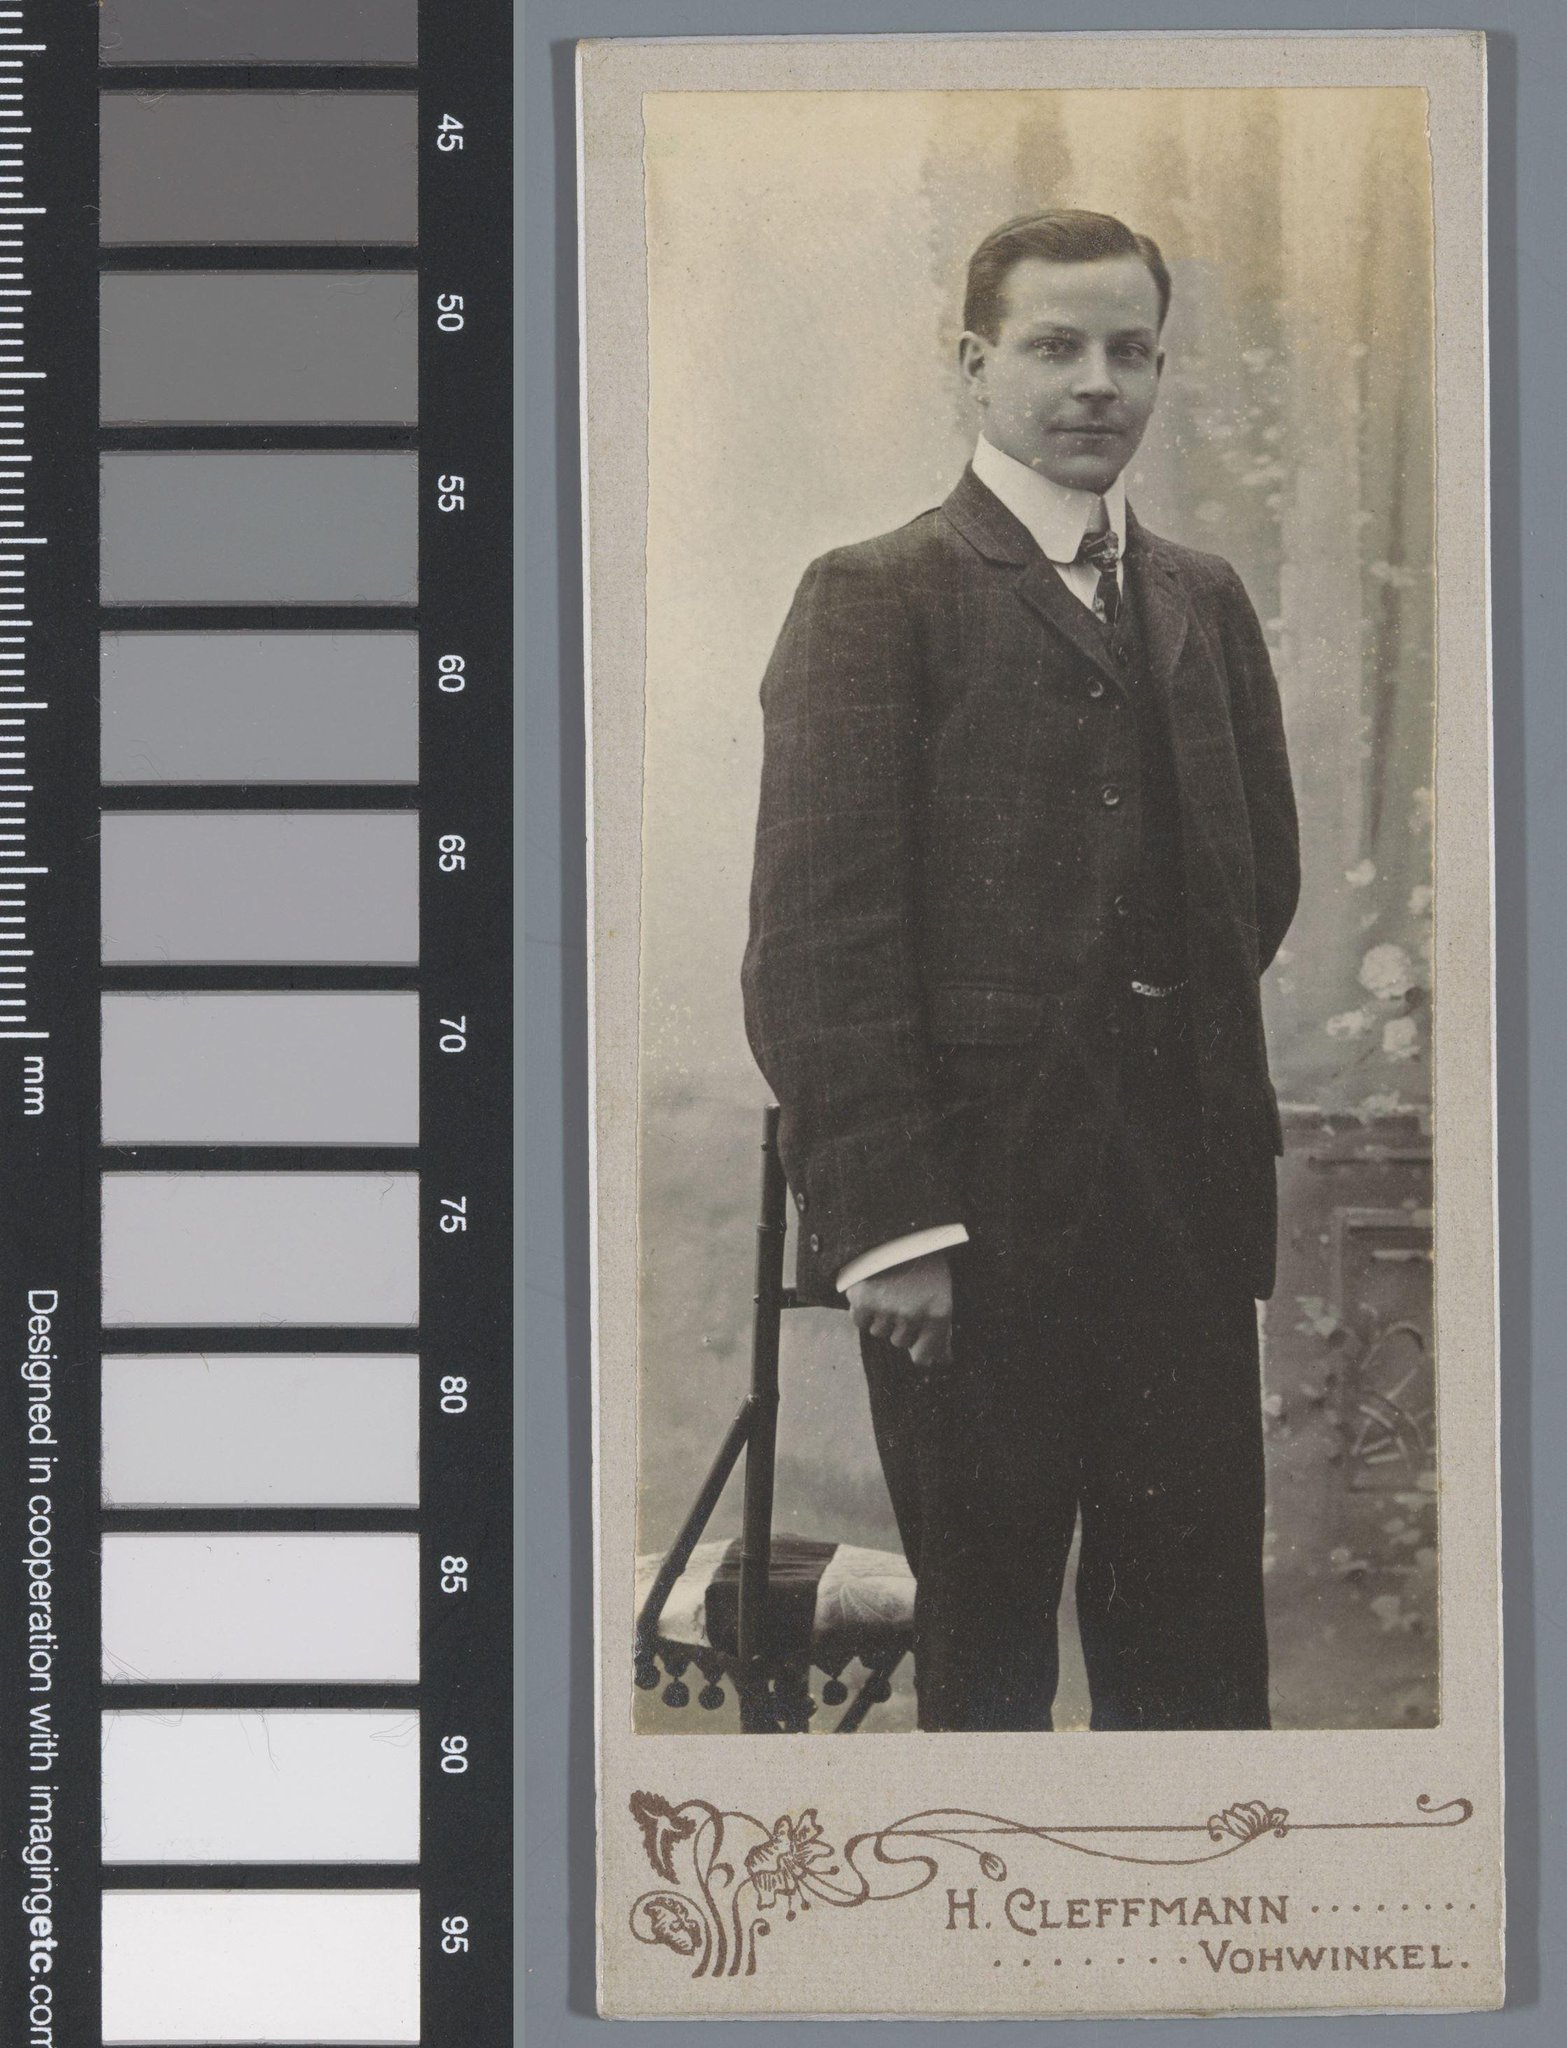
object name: carte de visite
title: Portret van een onbekende man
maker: h. cleffmann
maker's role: fotograaf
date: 1900-1914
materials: paper, cardboard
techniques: gelatin silver print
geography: wuppertal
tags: adult man, anonymous historical person portrayed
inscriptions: inscription: ‘Vohwinkel.’